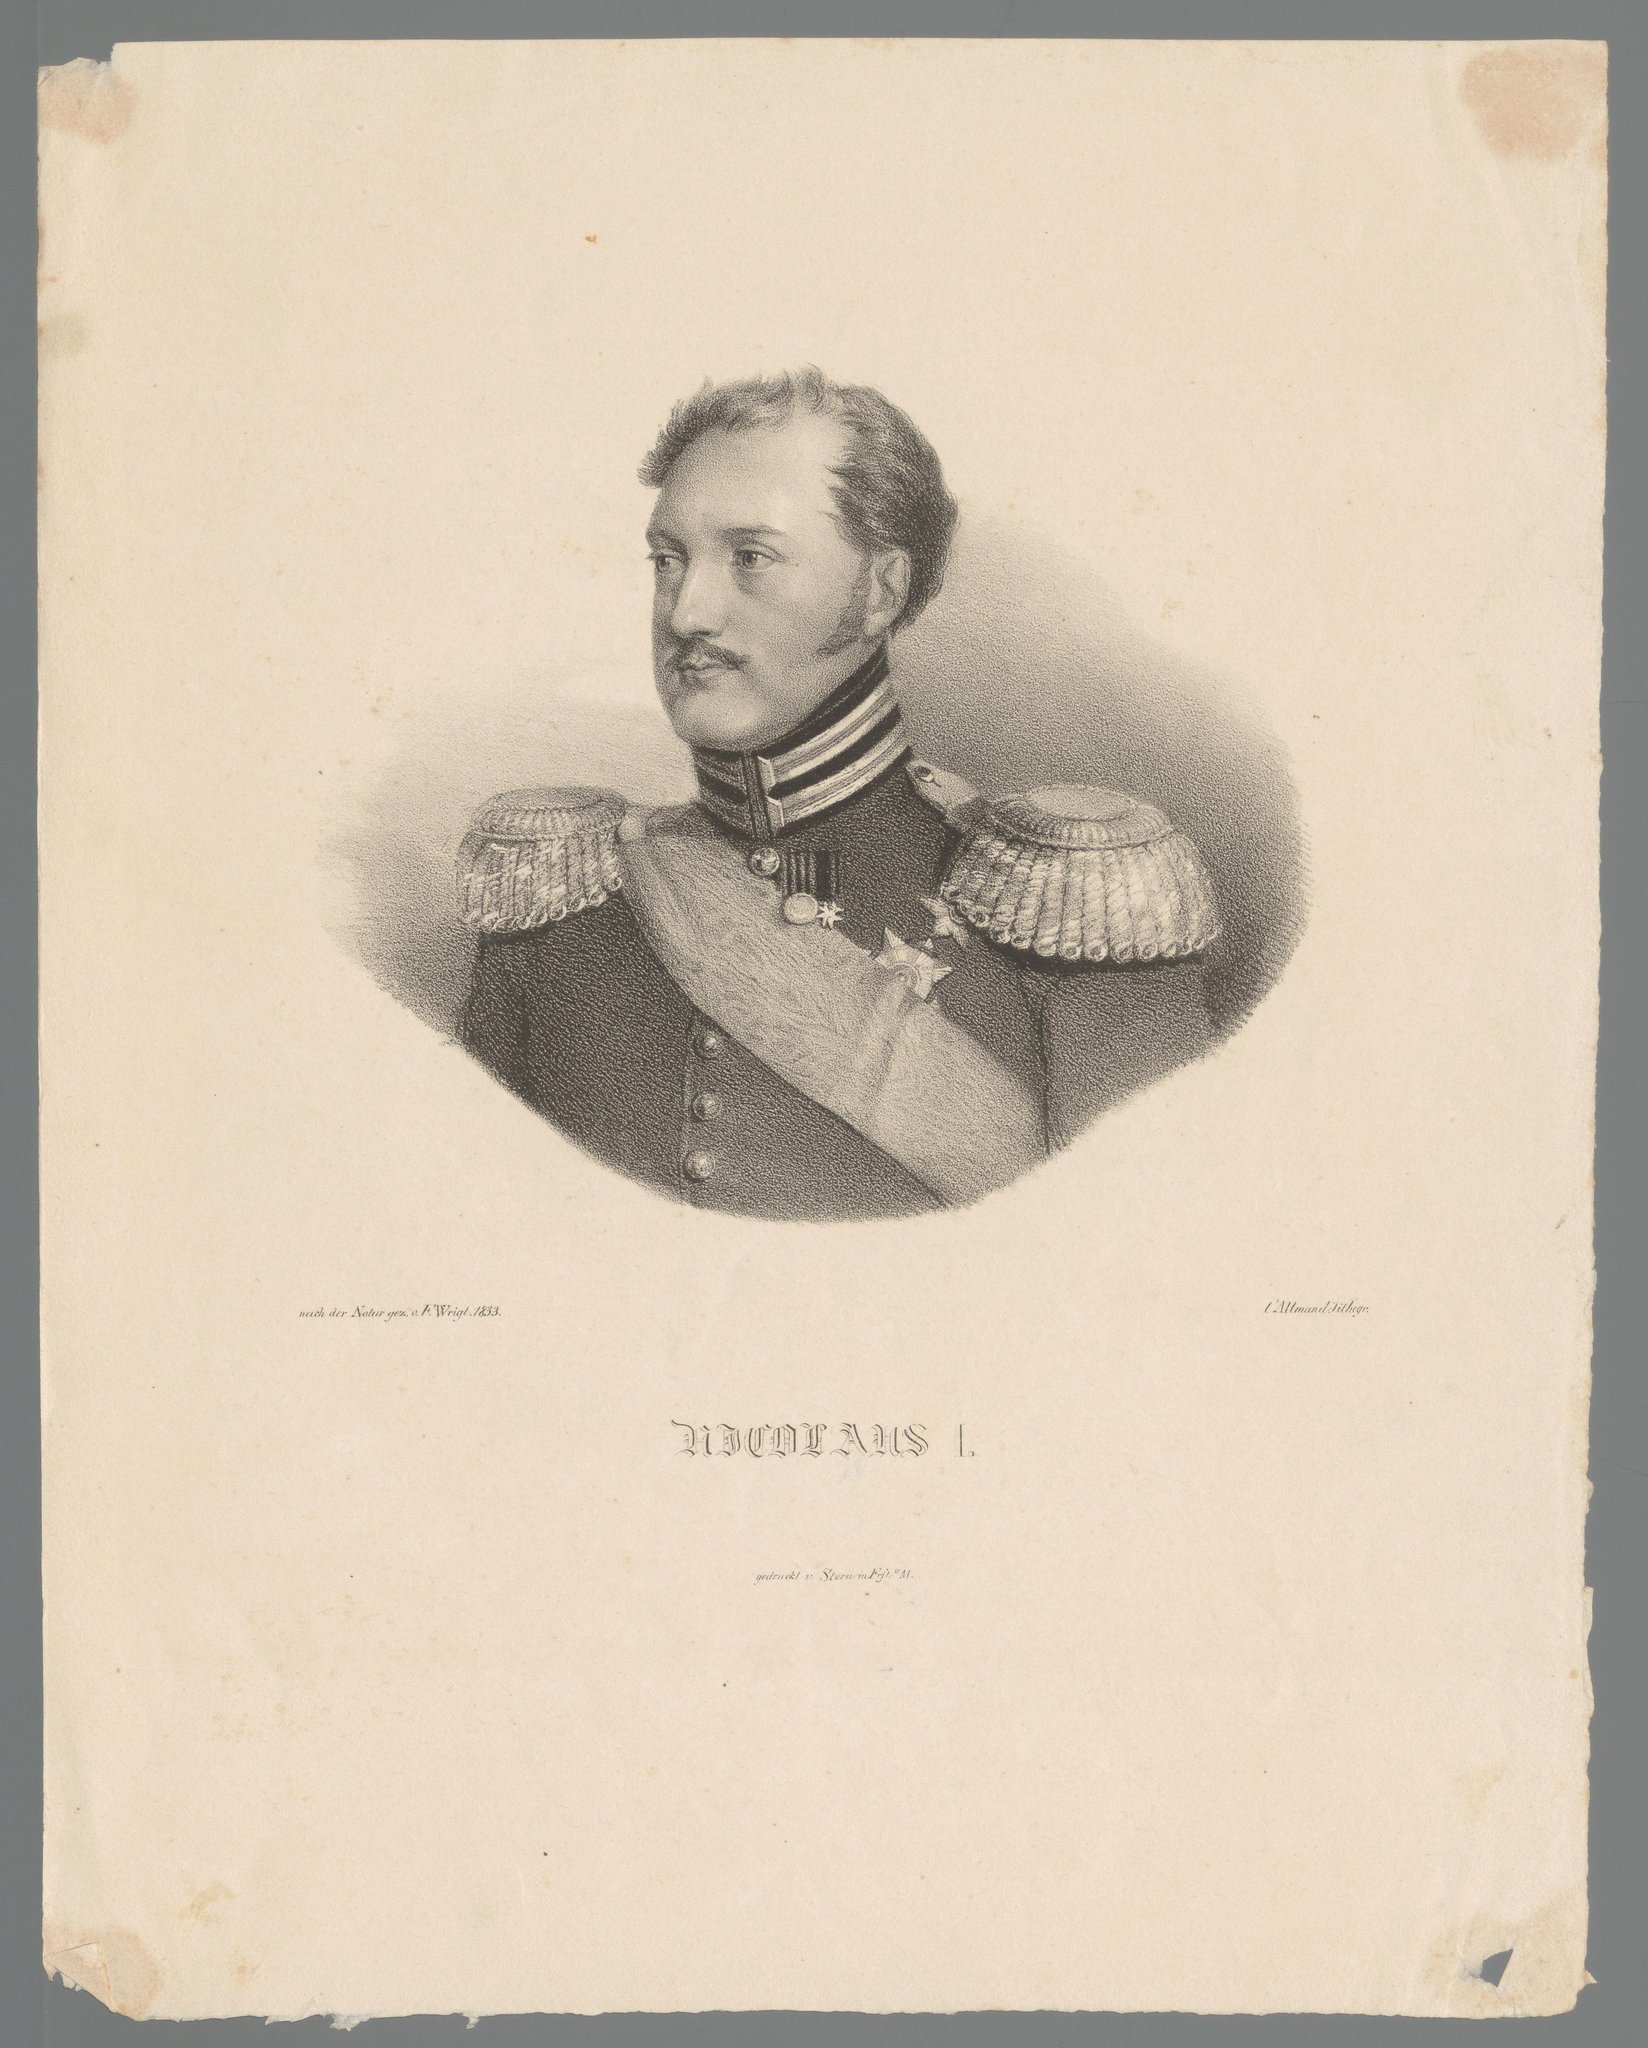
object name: print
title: Nicolaus I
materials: paper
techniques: lithograph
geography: frankfurt am main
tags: historical persons, emperor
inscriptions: collector's mark: Lugt 2228